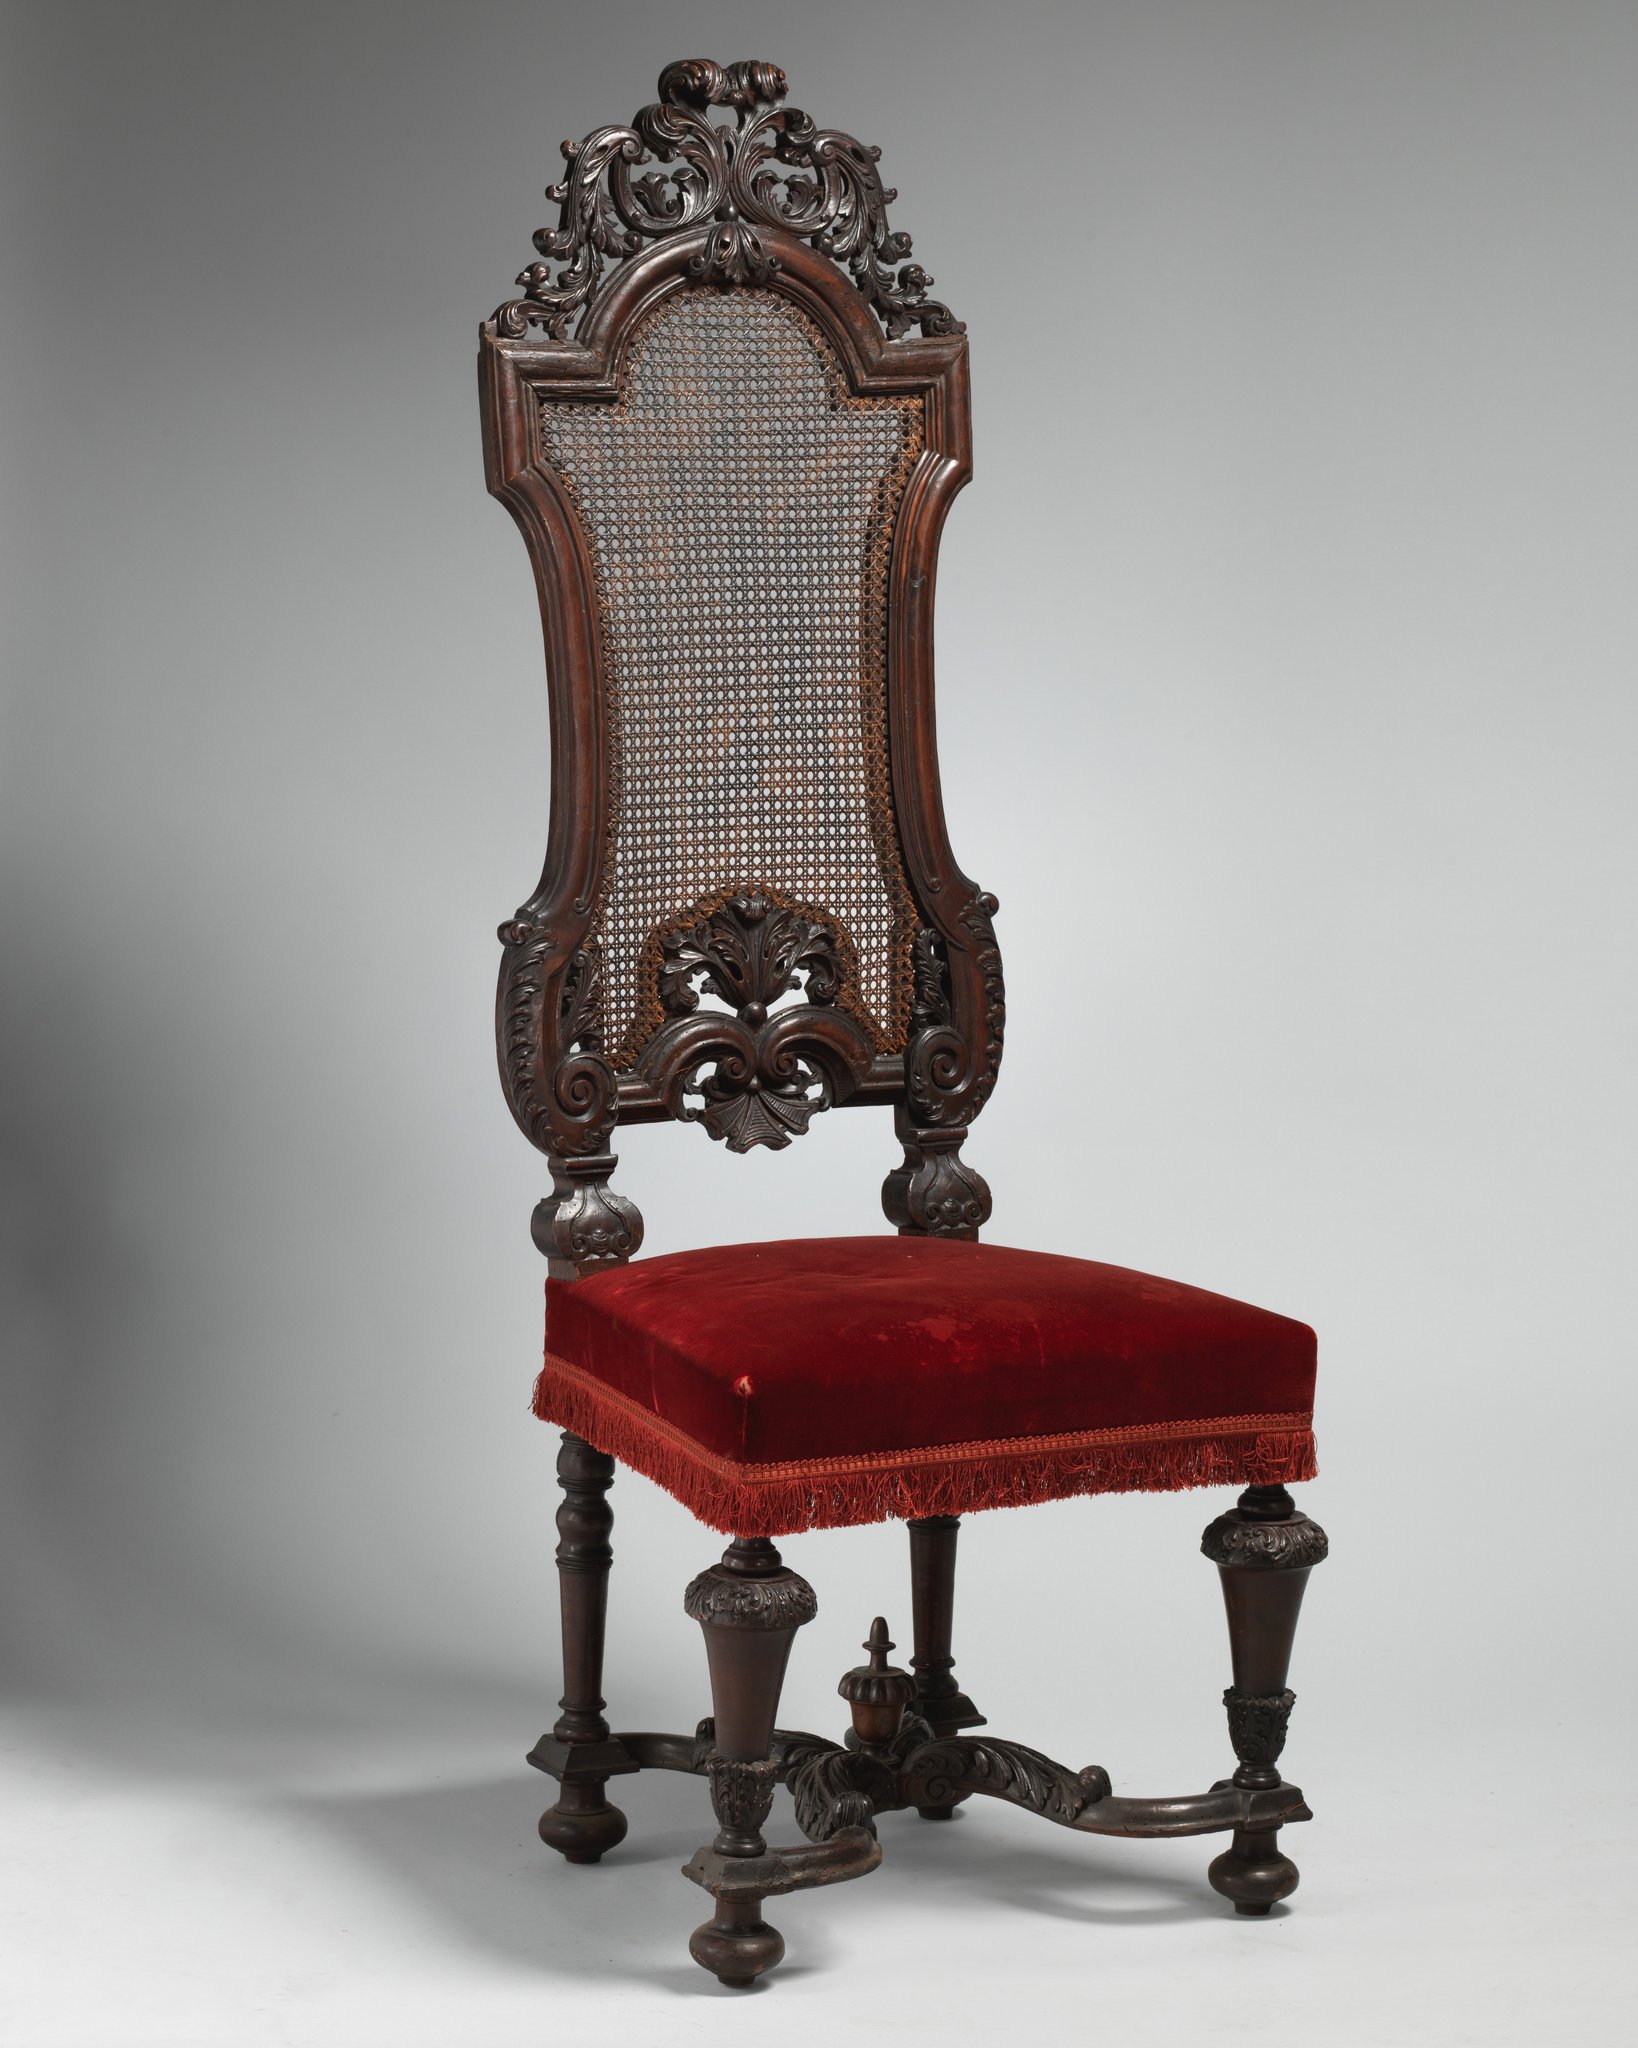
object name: chair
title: Chair (one of a set of six)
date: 1695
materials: velvet, wood